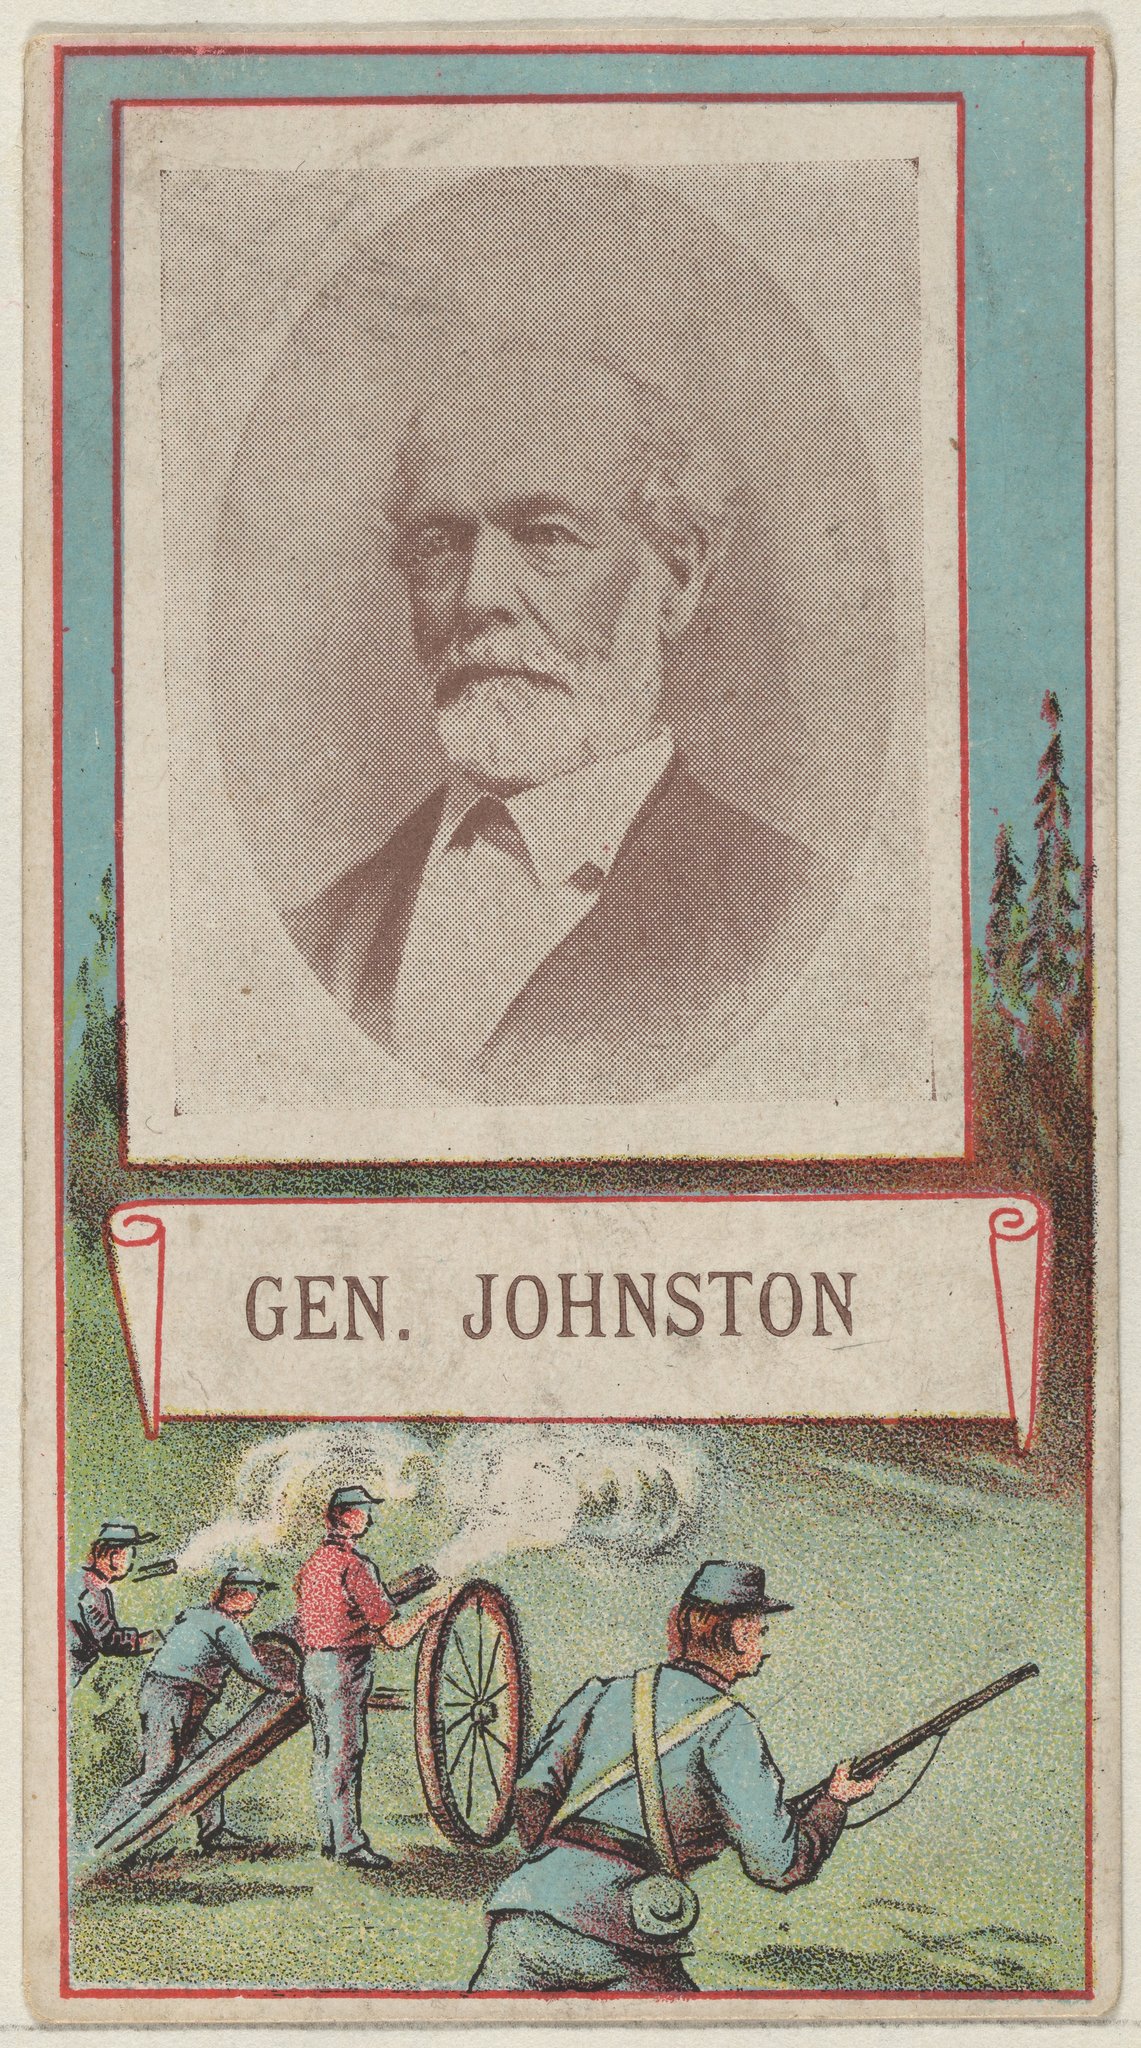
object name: print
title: General Johnston, from the "Generals" series (T64), issued by D.H. McAlpin & Co. Tobacco Company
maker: d.h. mcalpin & co. tobacco company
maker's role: publisher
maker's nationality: american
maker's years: 1857-1901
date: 1901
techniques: color lithograph